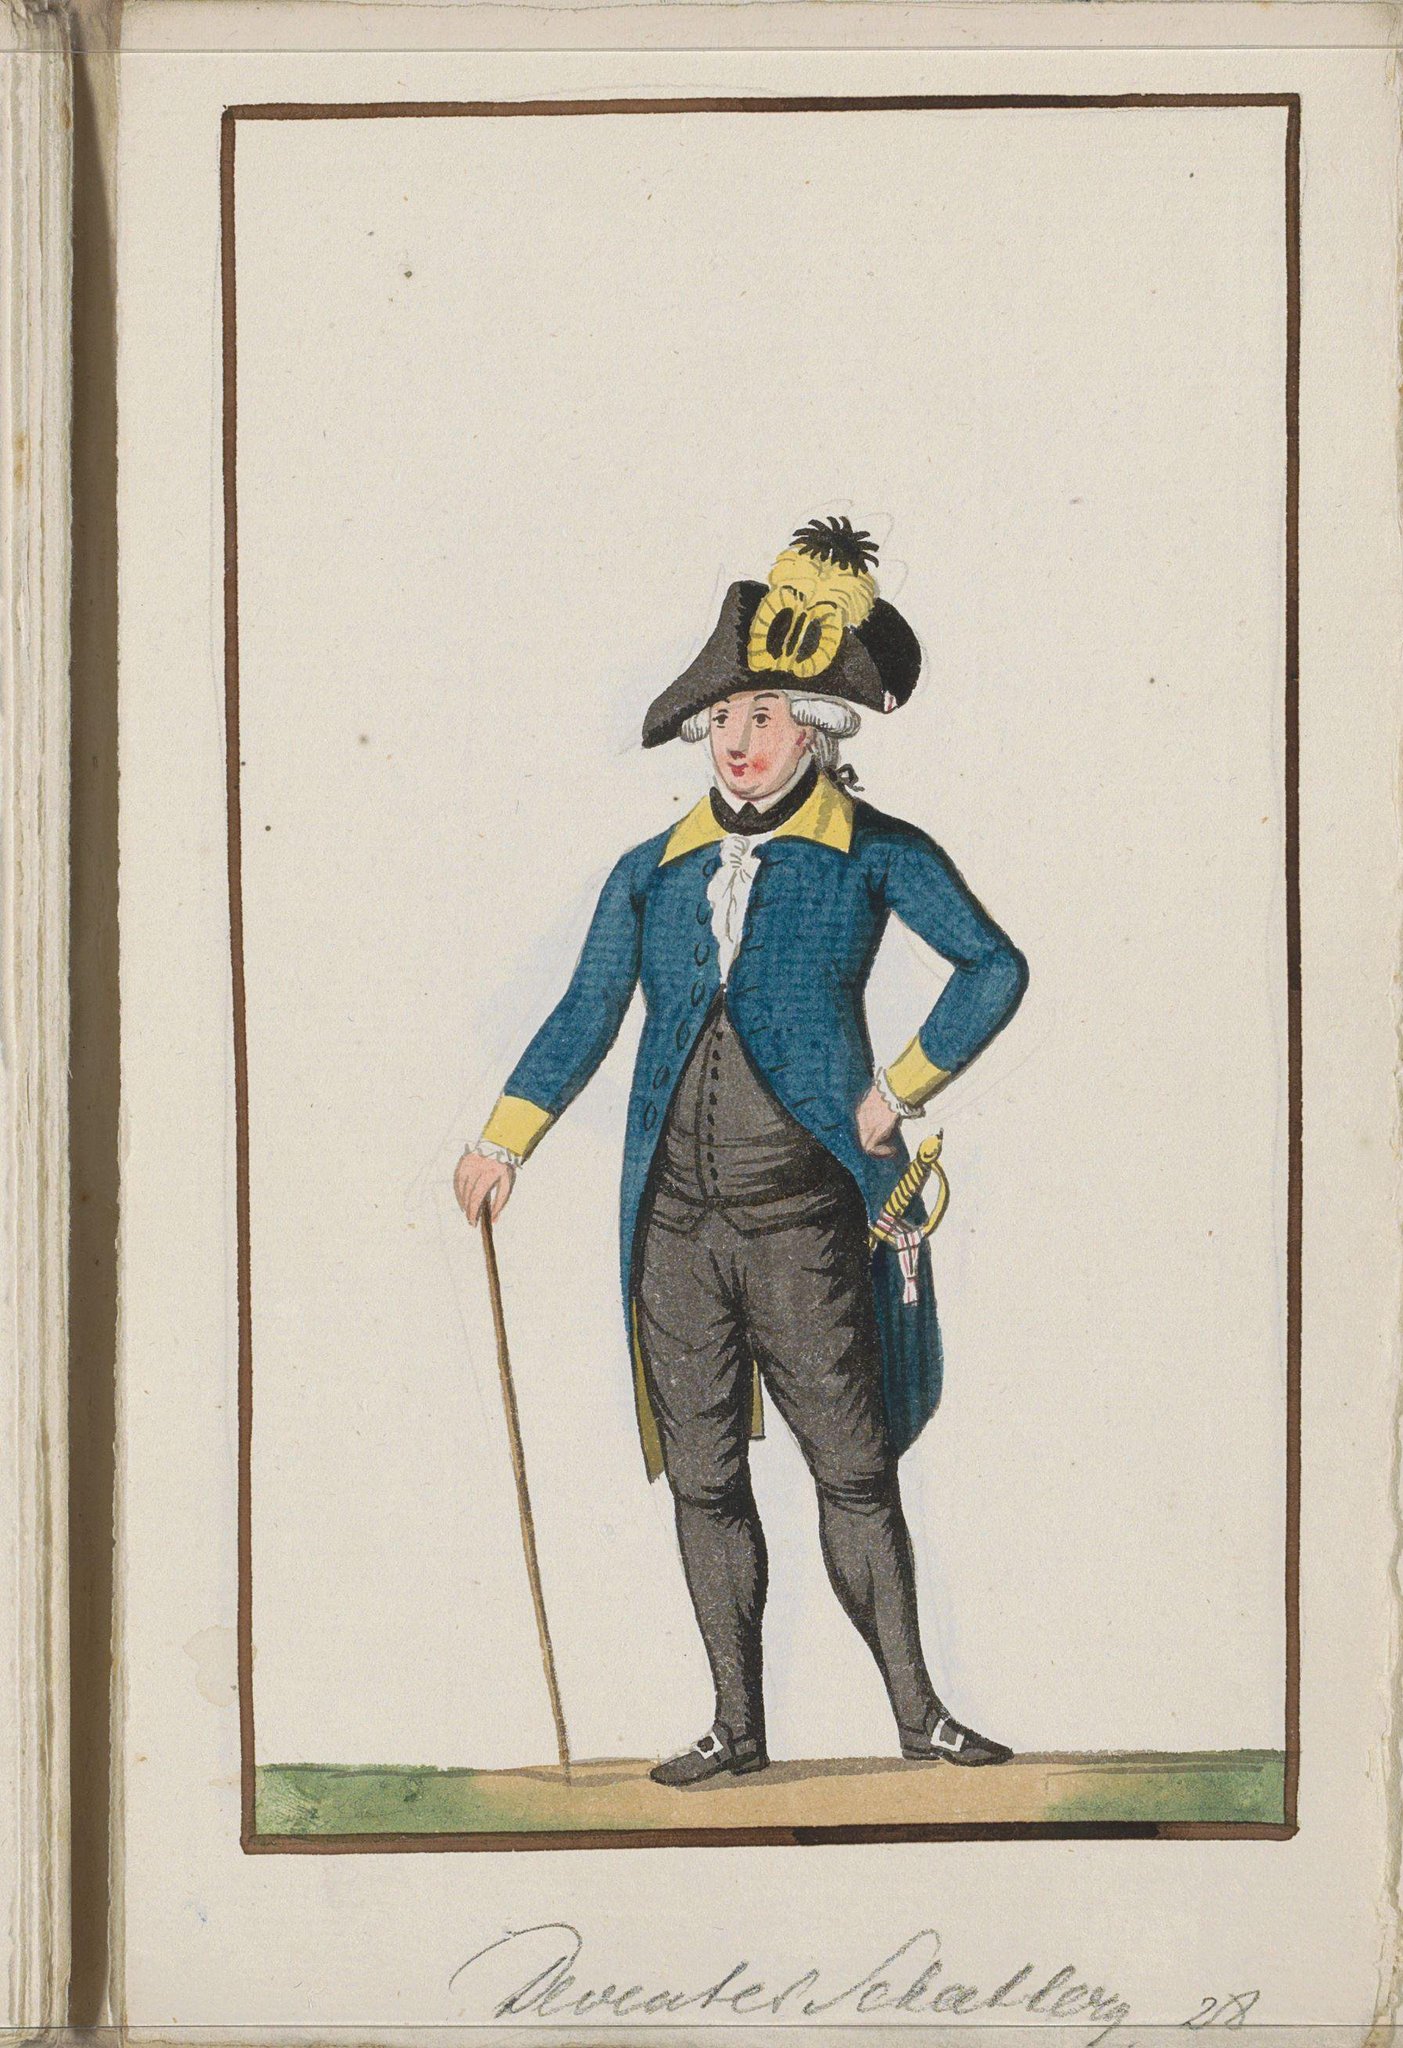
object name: costume print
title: deventer Schuttery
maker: Anonymous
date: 1789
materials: paper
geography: northern netherlands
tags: (military) uniforms (+ citizen soldiery, civil guard, citizen militia), deventer, patriots (1780-1795)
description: Montering of uniform van de schutterij van Deventer, ca. 1785. Onderdeel van een schetsboek met 41 gekleurde tekeningen van de monteringen van de gewapende schutterijen en burgercorpsen in Nederland in de periode ca. 1783-1789.